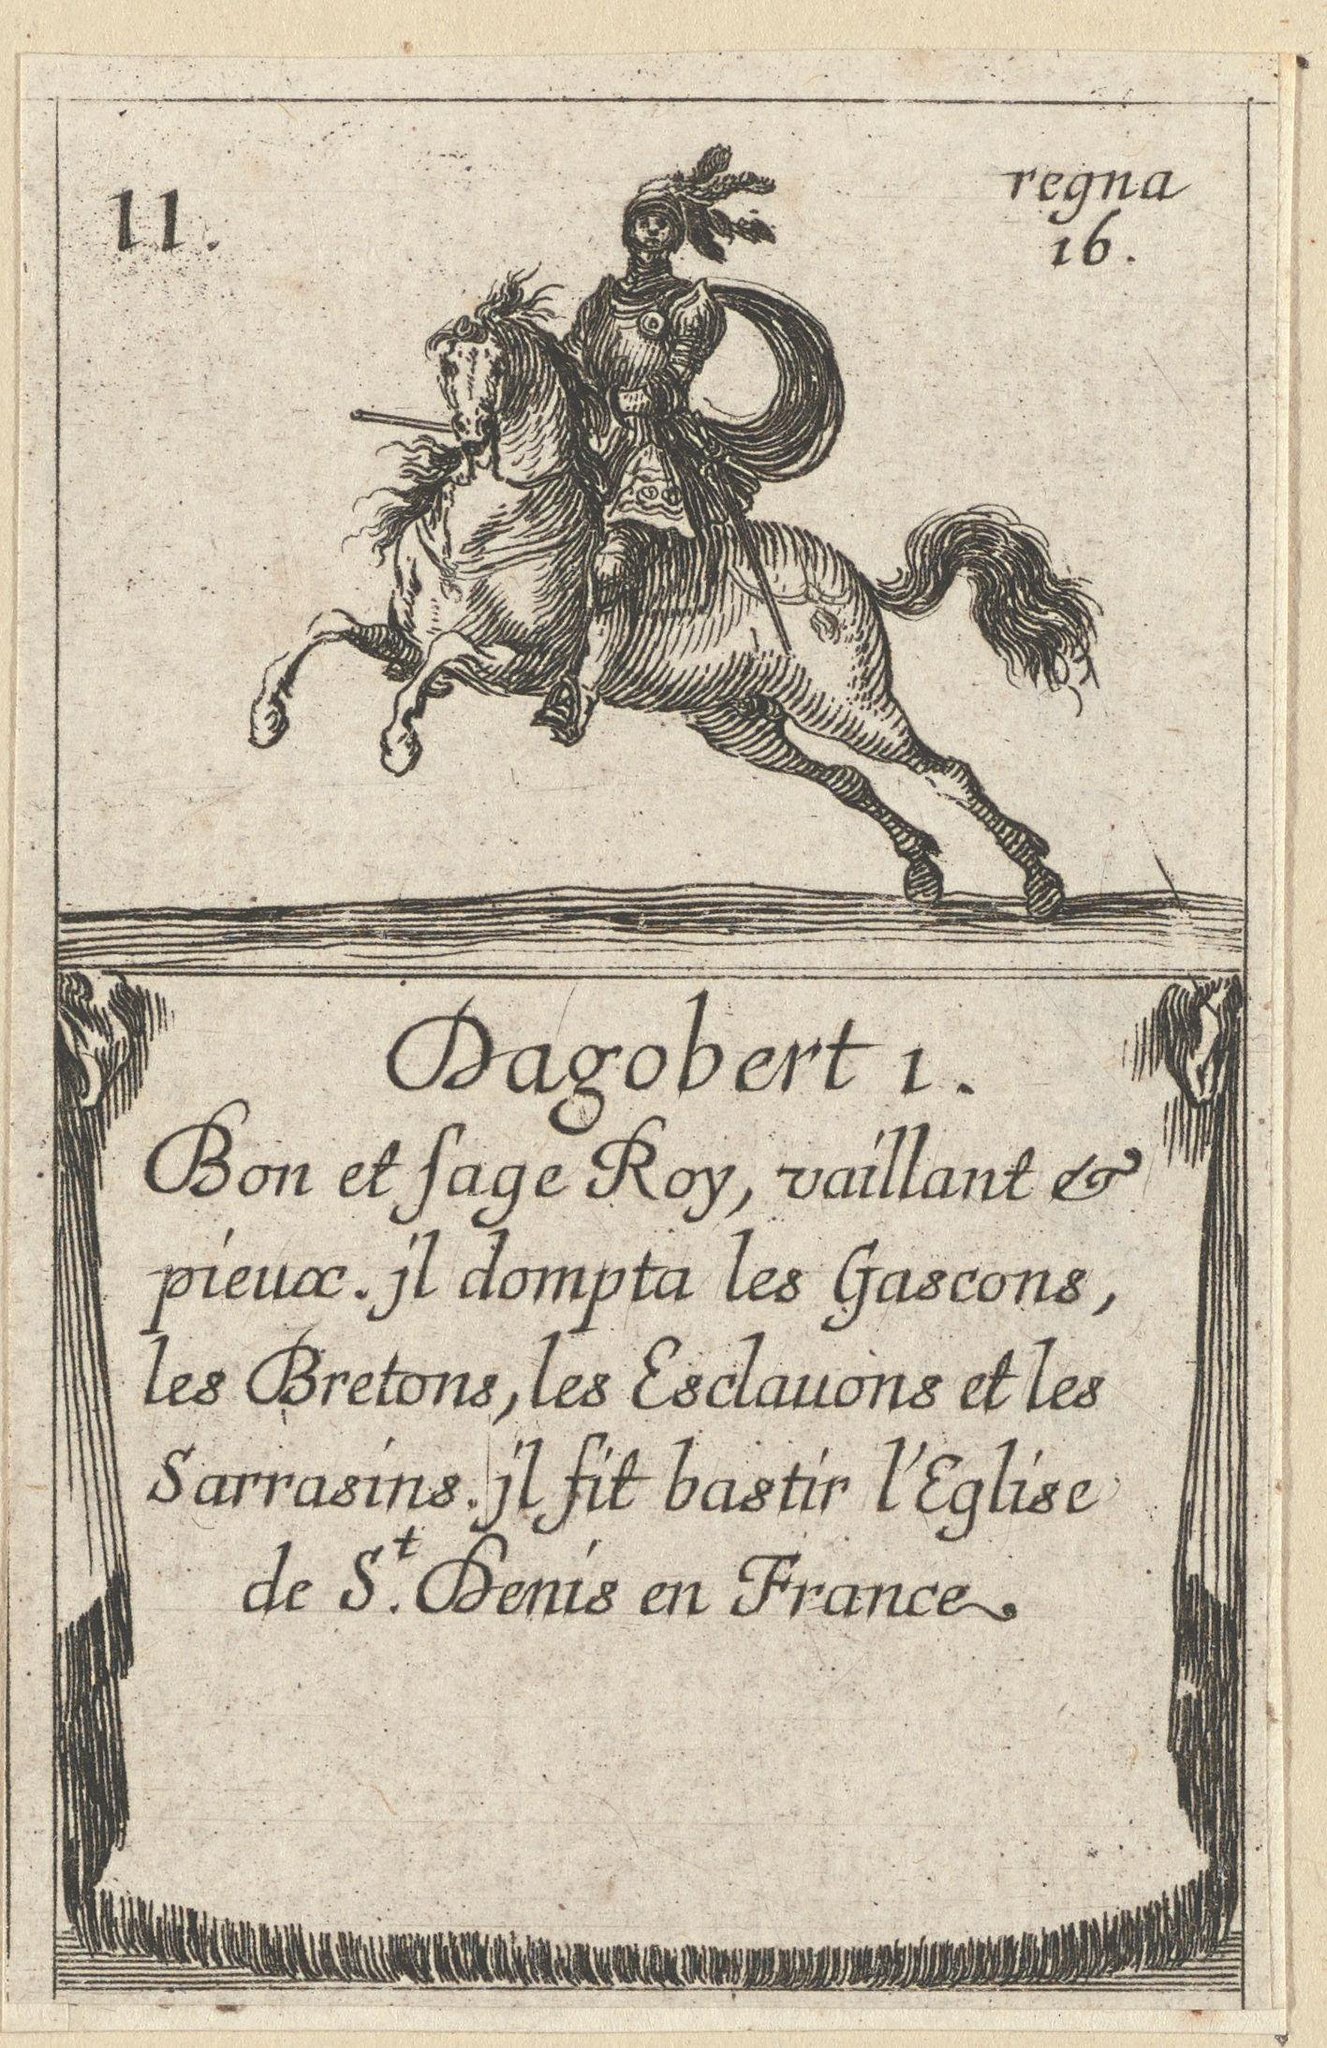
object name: print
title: Cartes des rois de France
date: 1620-1664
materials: paper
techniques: etching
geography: paris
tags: ruler, sovereign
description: Deze prent maakt deel uit van een kaartspel met 39 kaarten met voorstellingen van Franse koningen. De serie is uitgedacht door Jean Desmarests de Saint-Sorlin in opdracht van Kardinaal Mazarin. Het kaartspel werd gemaakt voor de jonge Lodewijk XIV, samen met het Jeu des Fables, Jeu des Reynes Renommées en Jeu de la géographie.